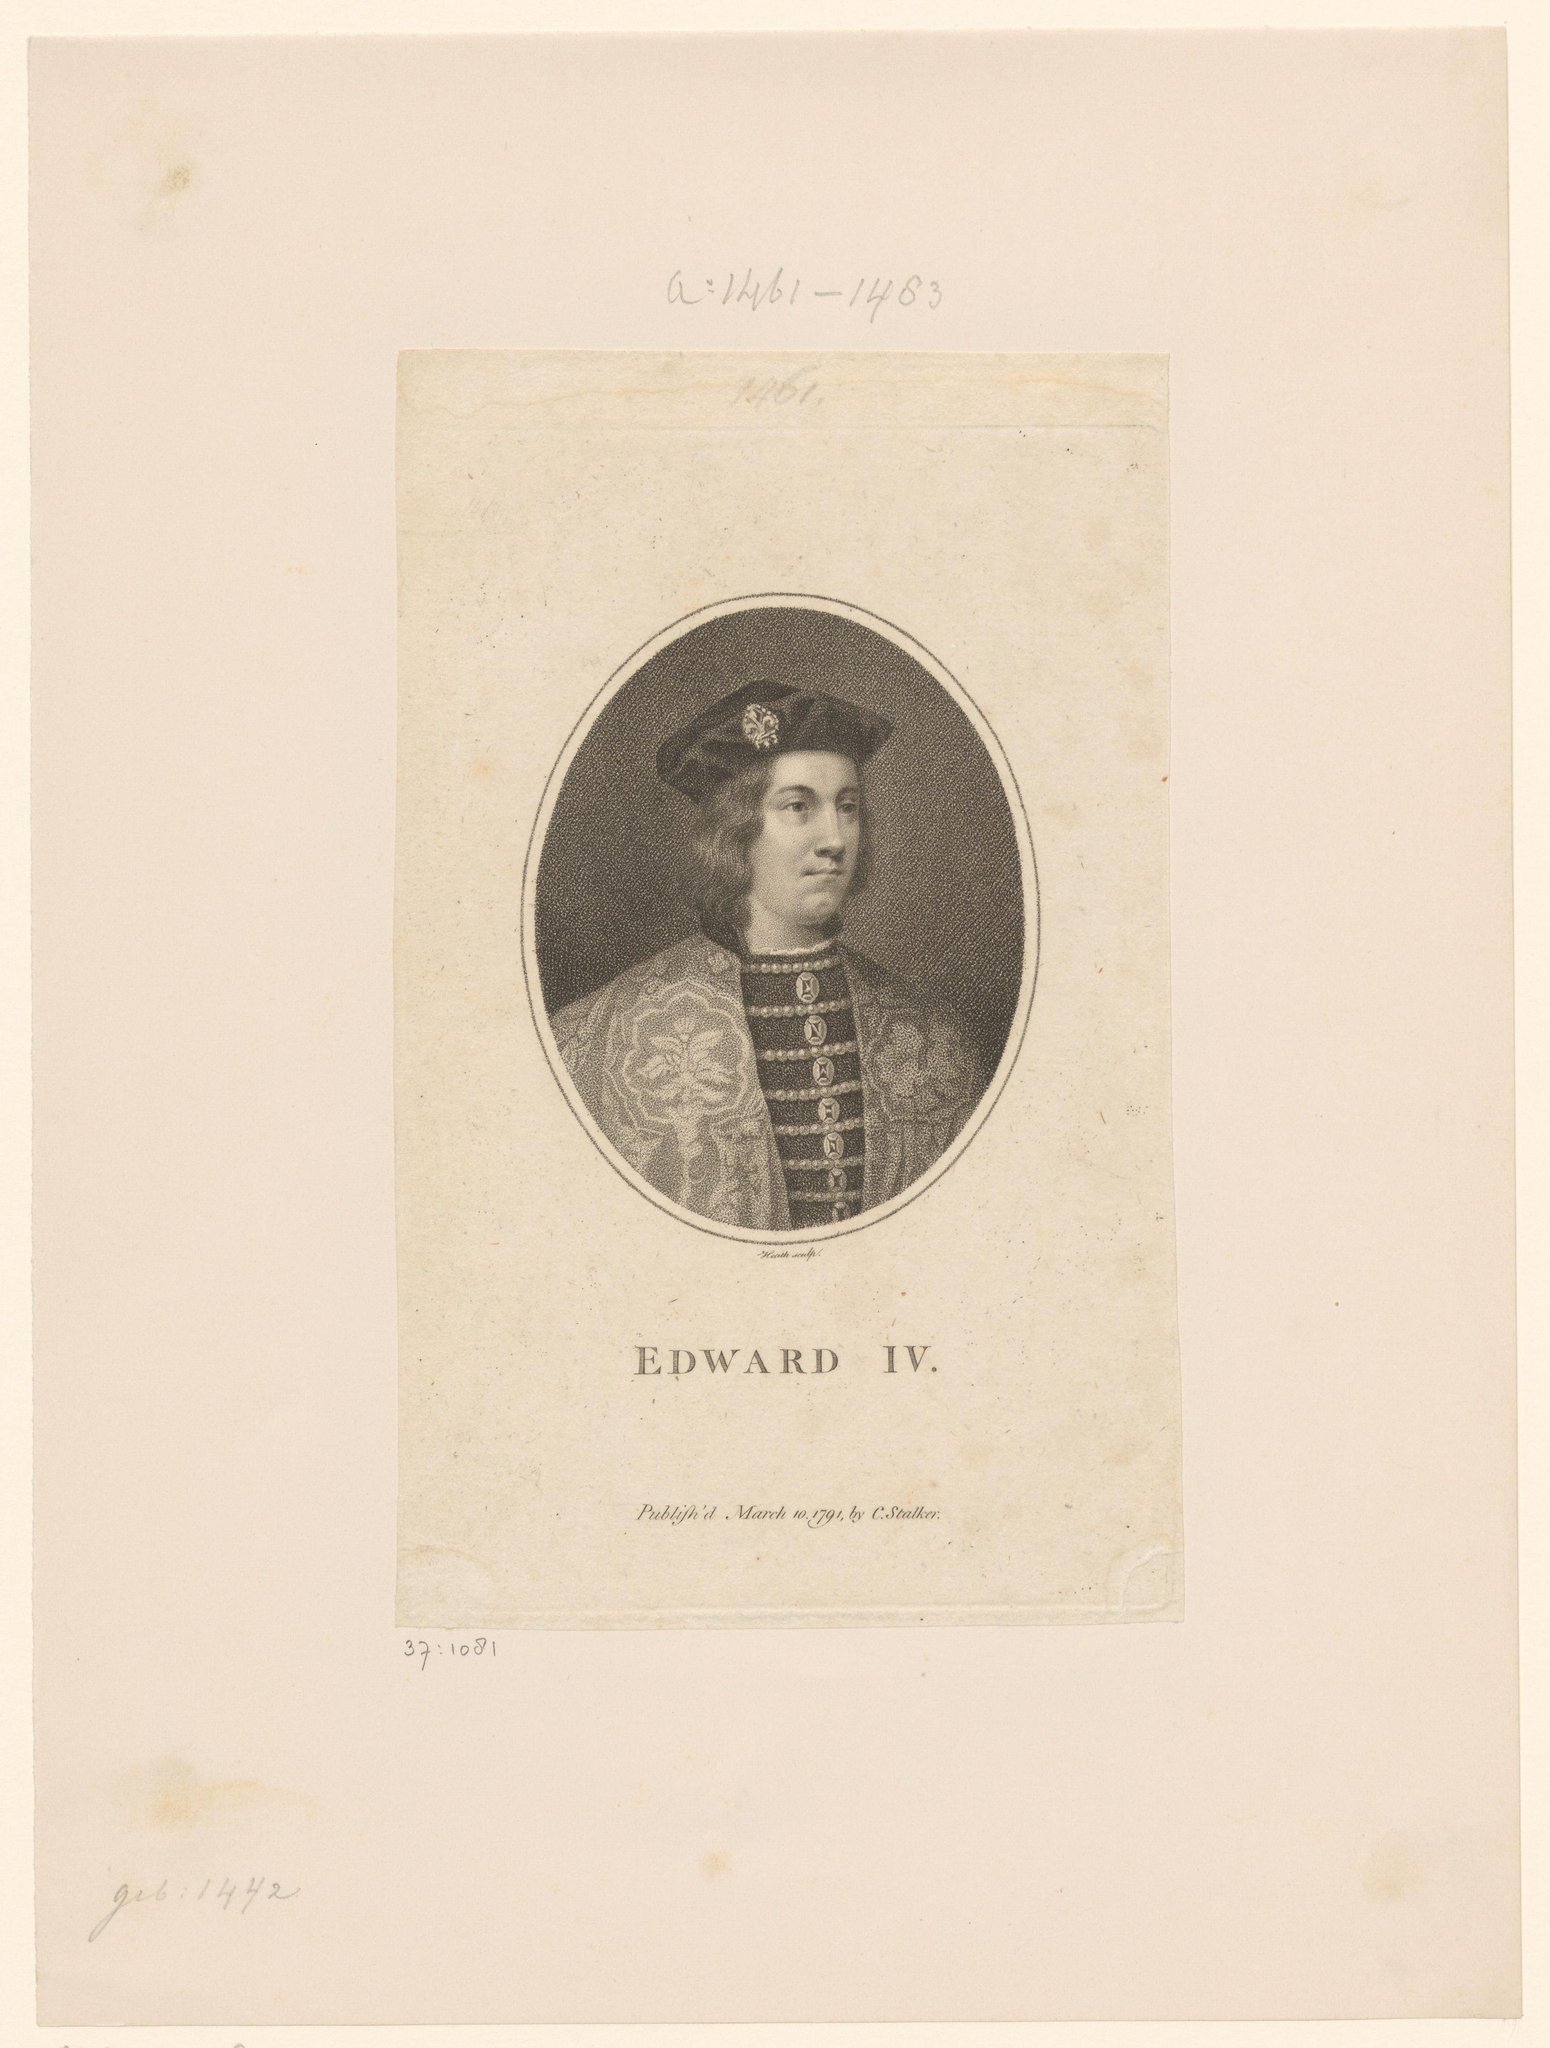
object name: print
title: Edward IV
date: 1703-1791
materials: paper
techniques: stippling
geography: london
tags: london, historical persons, king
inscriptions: collector's mark: Lugt 2228